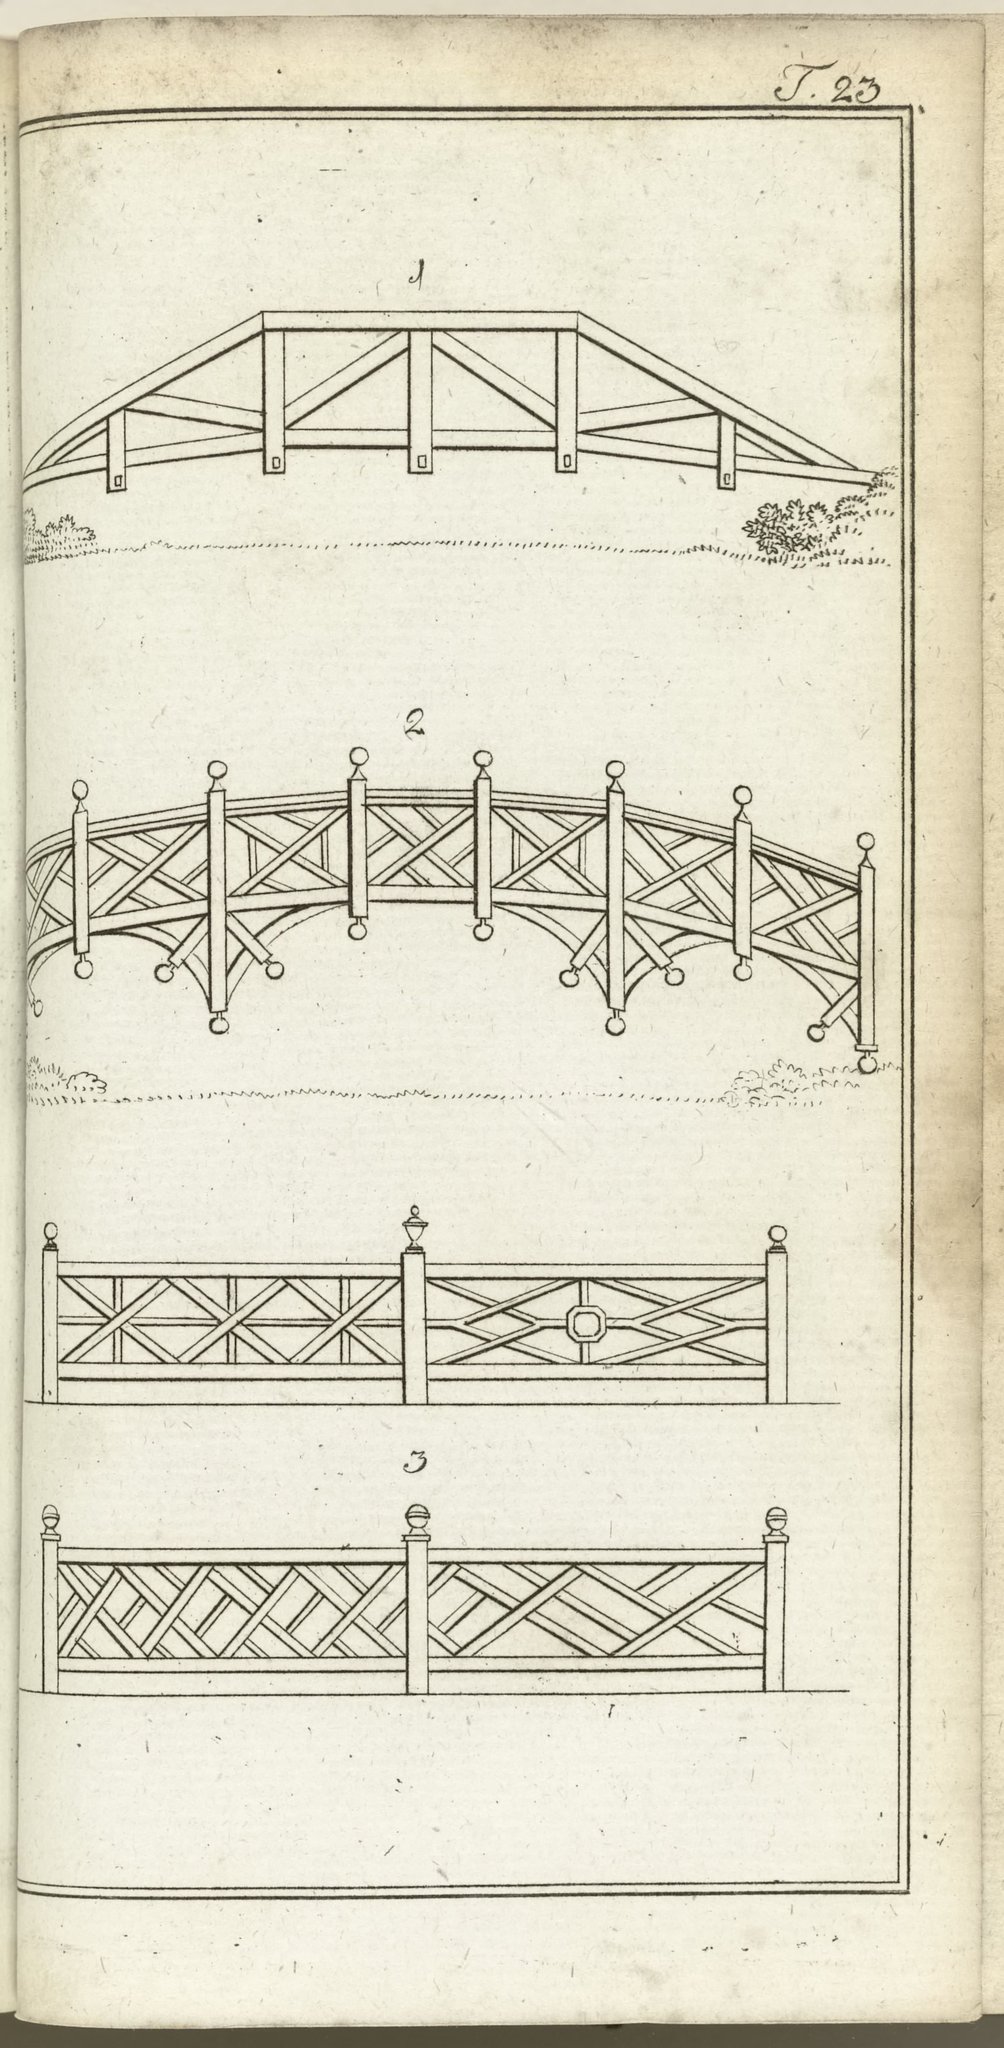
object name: magazine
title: Journal des Luxus und der Moden 1790, Band V, T.23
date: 1790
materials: paper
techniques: etching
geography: weimar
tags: fashion plates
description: Prent uit het modetijdschrift Journal des Luxus und der Moden, uitgegeven door Friedrich Justin Bertuch en Georg Melchior Kraus, Weimar, 1786-1826.